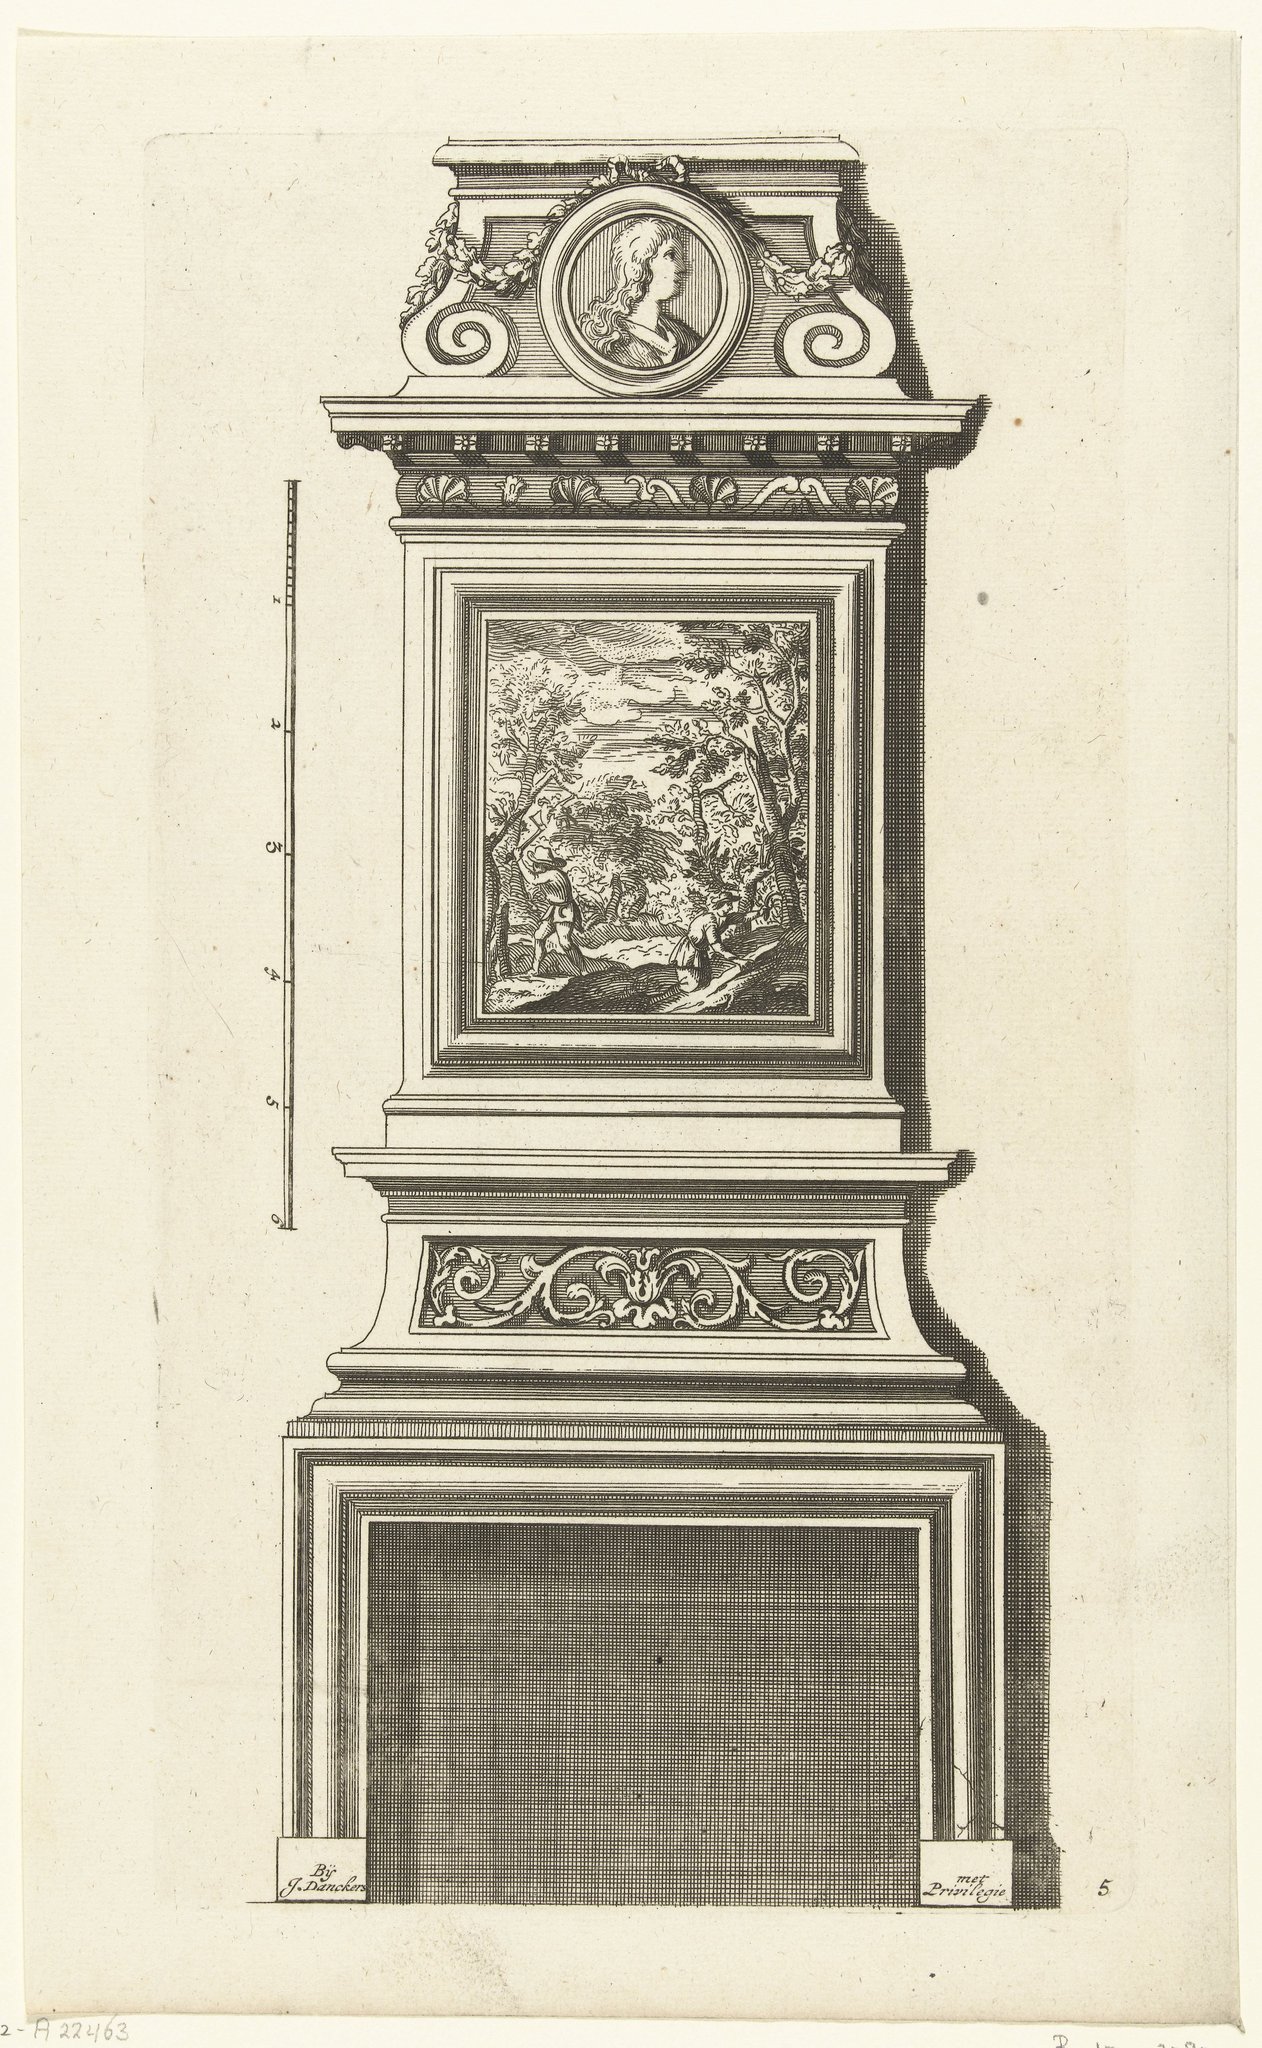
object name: ornament print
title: Verschyde Schoorsteen Mantels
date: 1675-1686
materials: paper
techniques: etching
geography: amsterdam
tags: chimney-piece, mantelpiece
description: Boven het tablet van de schoorsteenboezem hangt een fries met bladranken, daarboven hangt een rechthoekig schilderij met een landschap en twee houthakkers.